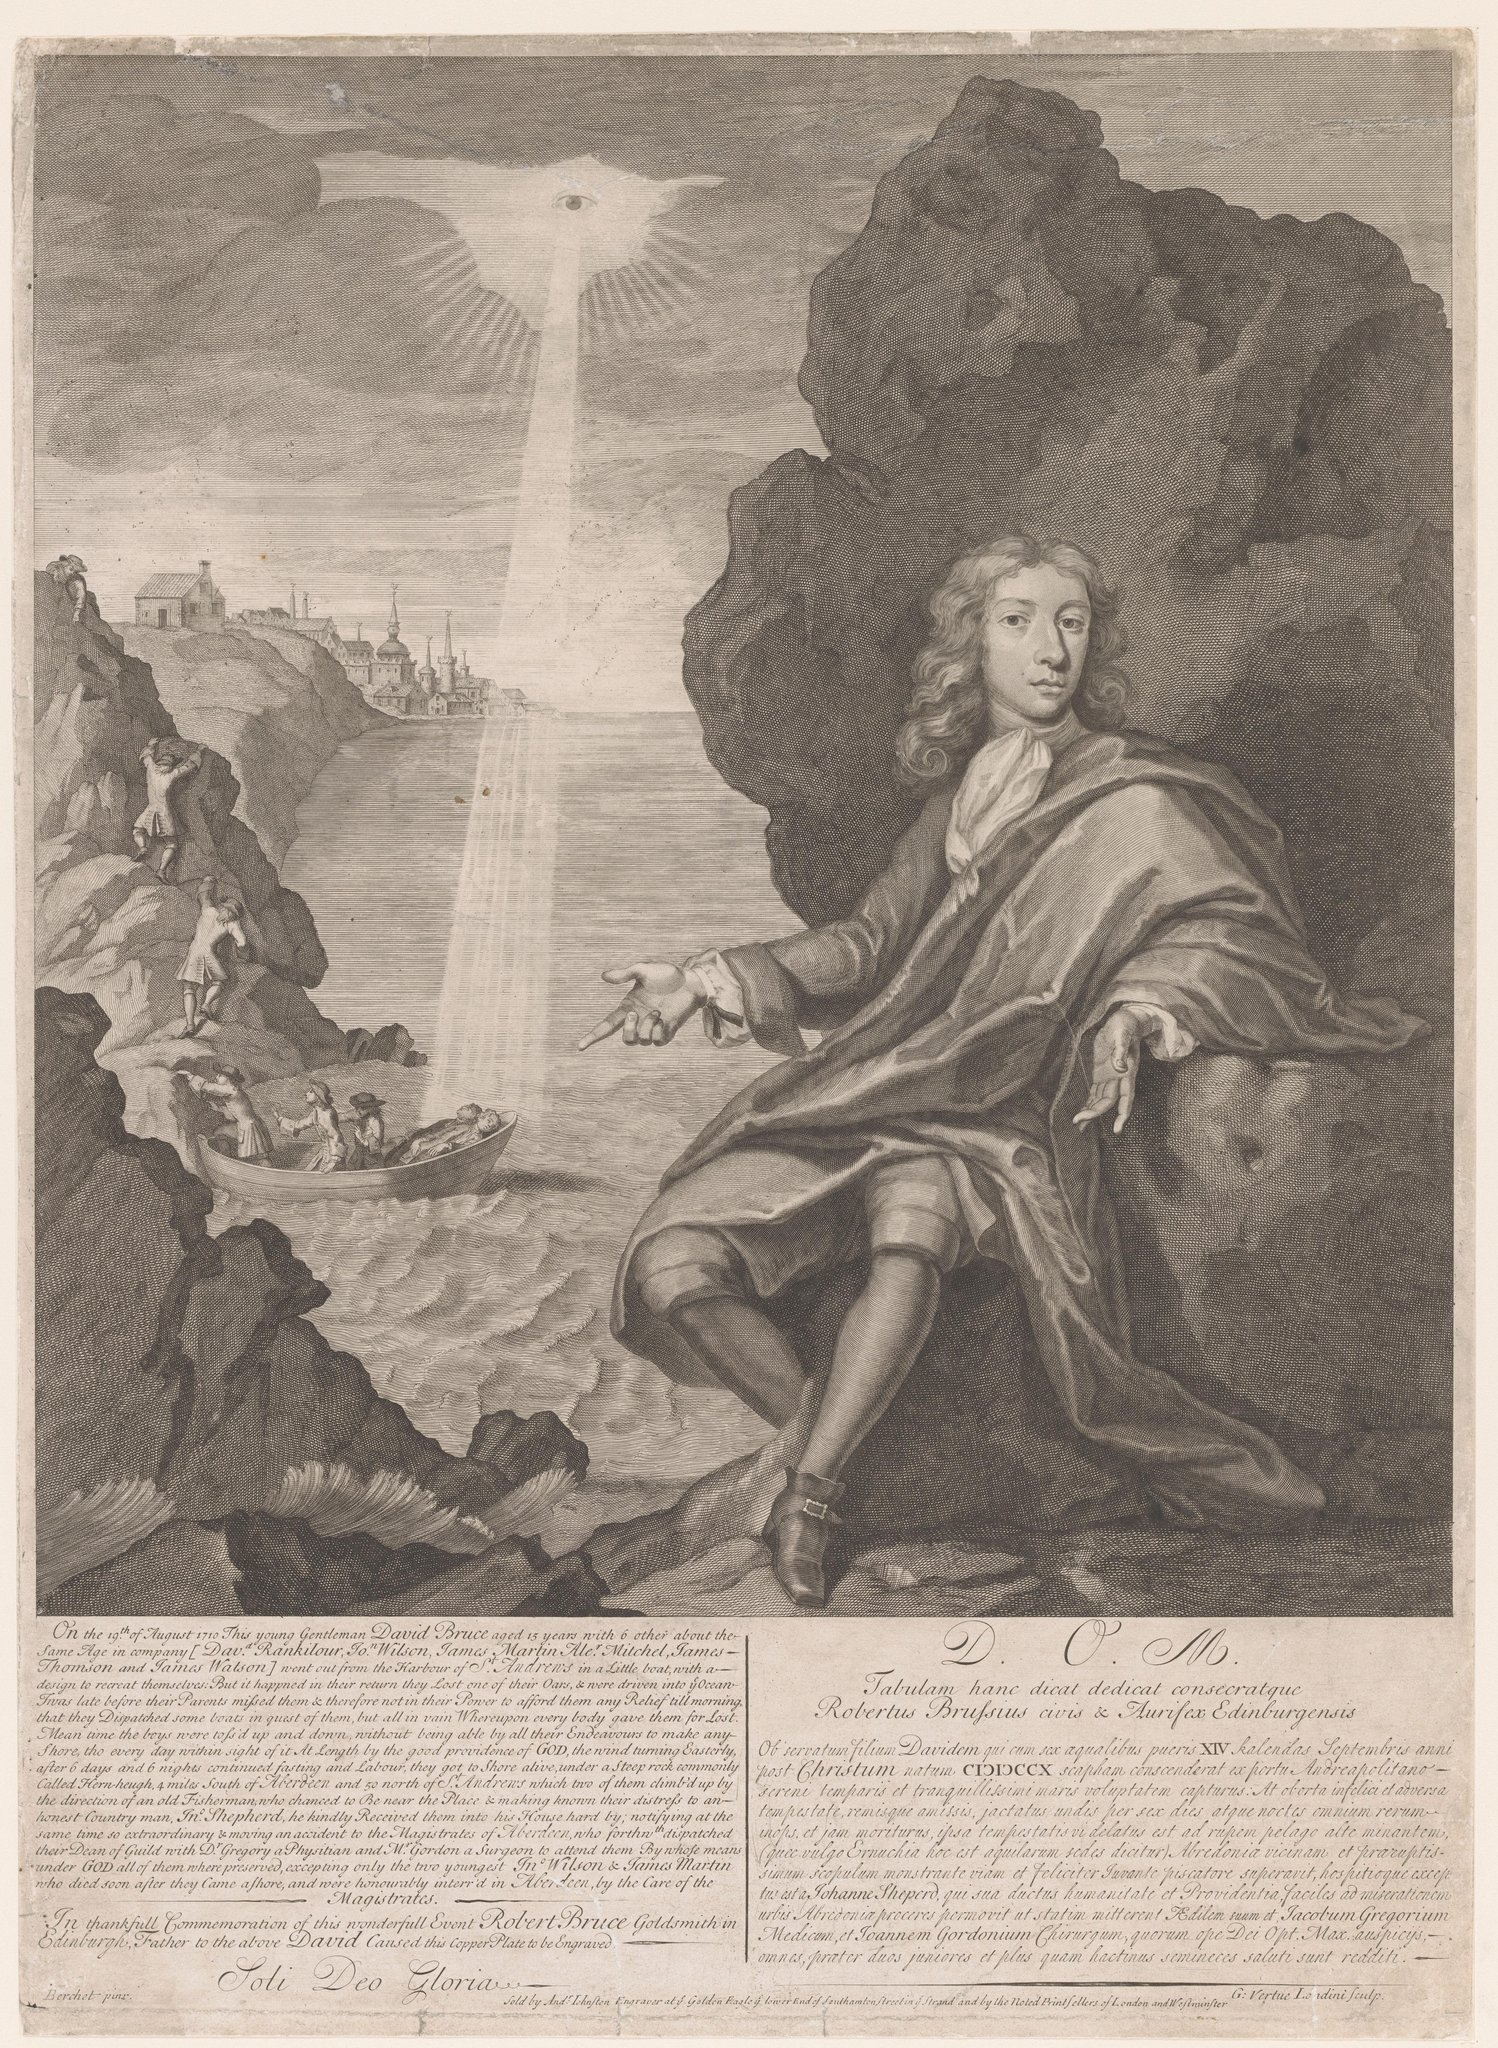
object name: print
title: Portret van David Bruce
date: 1710-1712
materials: paper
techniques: engraving, etching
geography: london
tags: historical persons, rocky coast, rowing-boat, canoe, etc., the all-seeing eye, triangle with eye ~ symbol of god the father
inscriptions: collector's mark: Lugt 2228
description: Onder de prent een uitleg over de voorstelling in het Engels en Latijn. David Bruce zit rechts op een rots. Links komt de roeiboot waarmee Bruce en zes anderen zes dagen lang op zee hebben rondgedobberd aan bij de kust van Aberdeen. Twee van hen klimmen al op de rots, waar boven de rots een visser zijn arm uitstrekt. Twee jongens liggen ziek in de boot. Boven de roeiboot breekt door de wolken het oog van God.